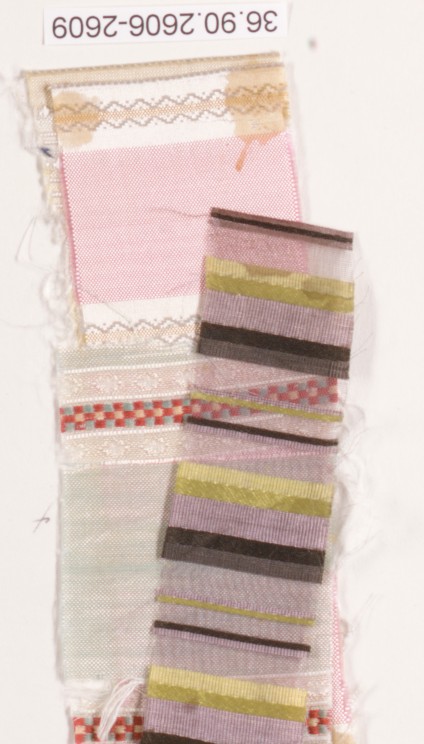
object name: ribbon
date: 1801-1900